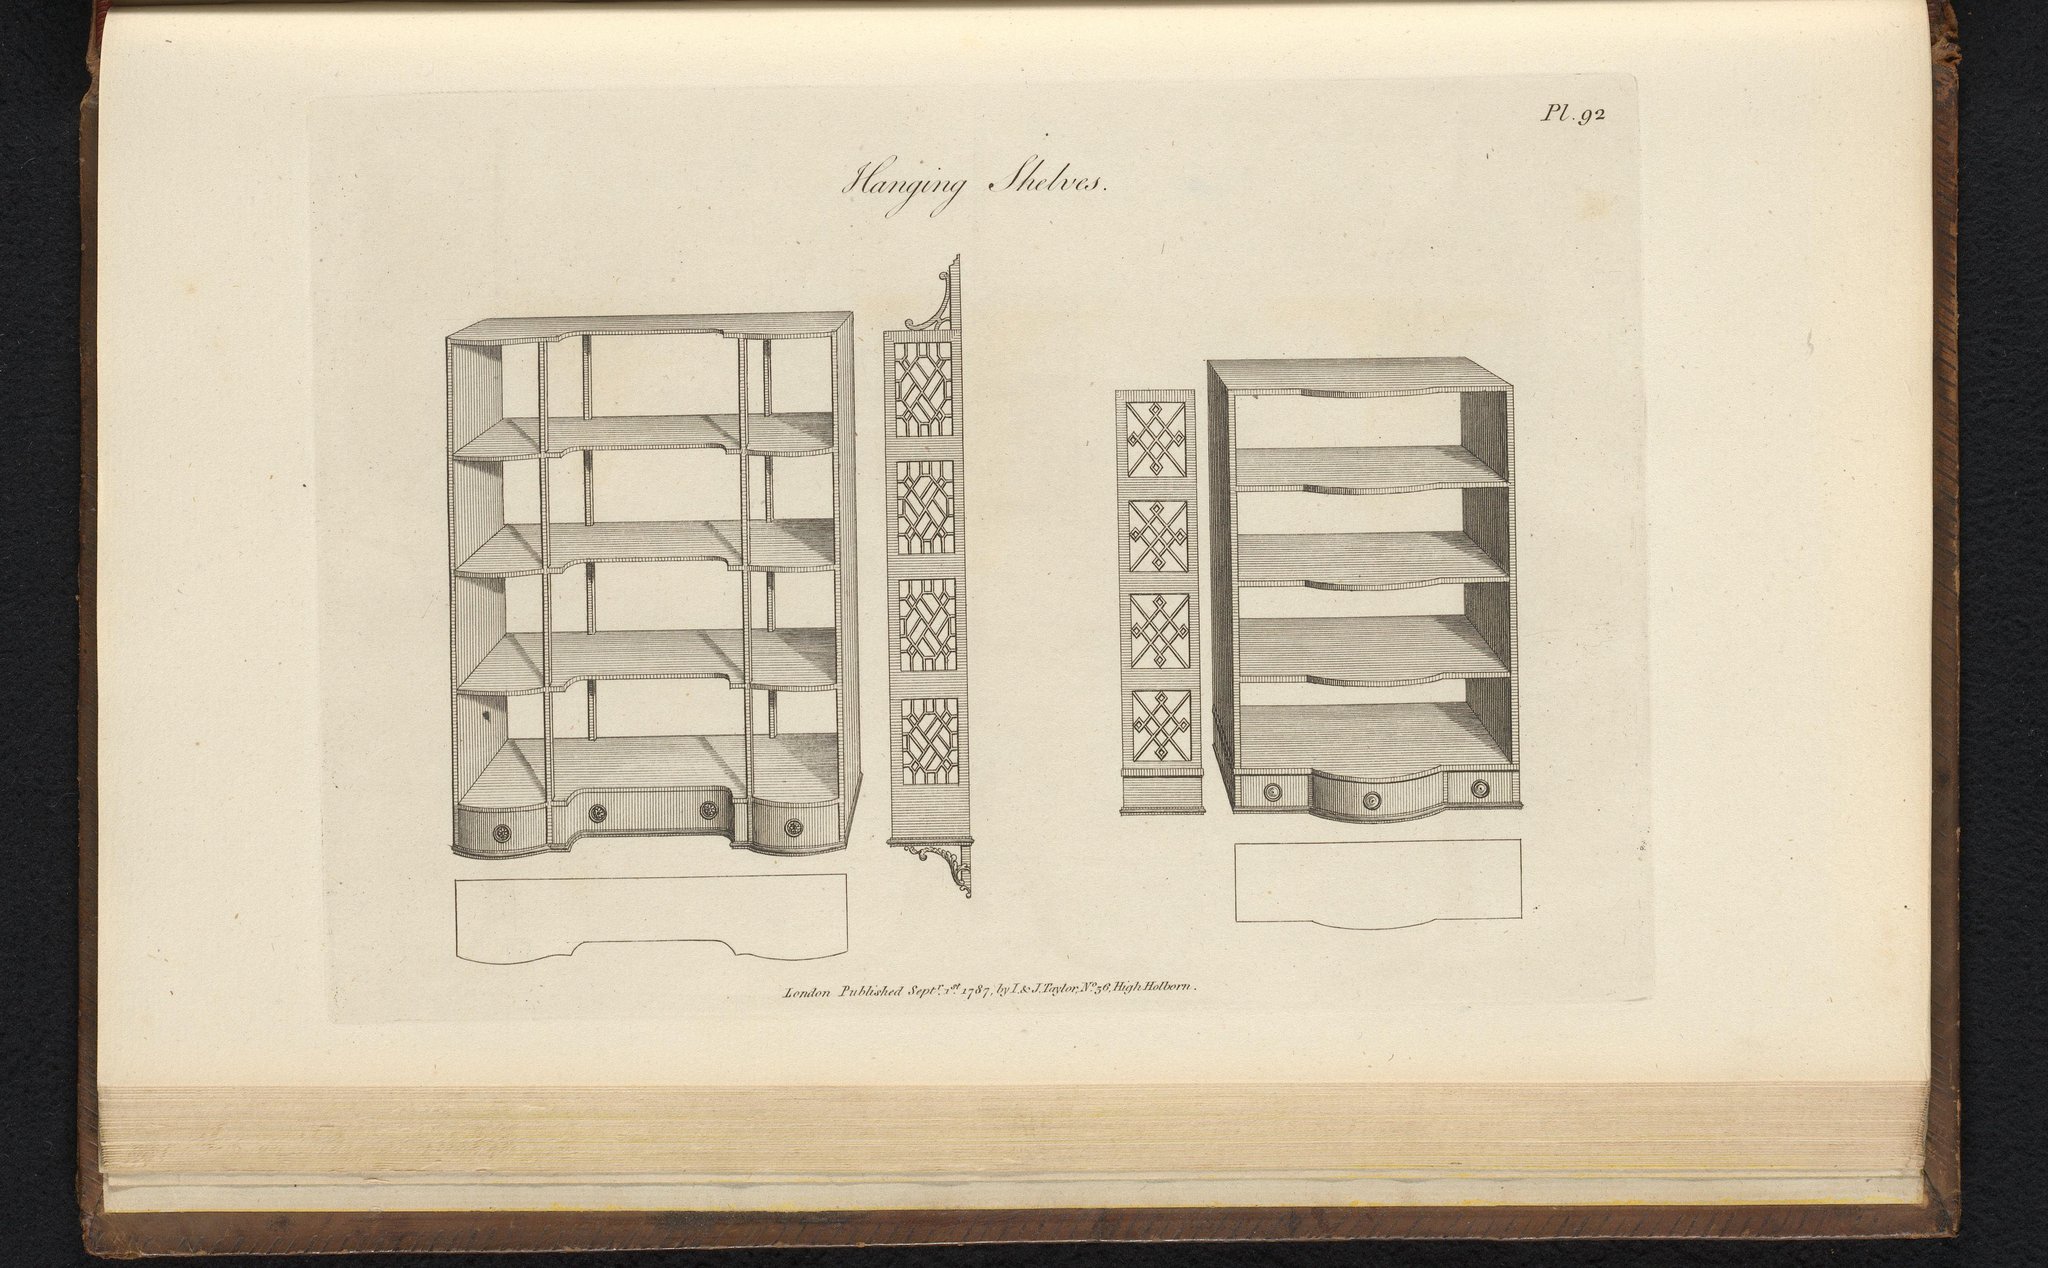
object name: page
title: Twee kasten met zijaanzichten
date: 1787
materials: paper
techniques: engraving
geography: holborn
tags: ornamental cupboard, bookshelves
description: Genummerd: Pl. 92. Gemerkt: B. Prent maakt deel uit van een boek.